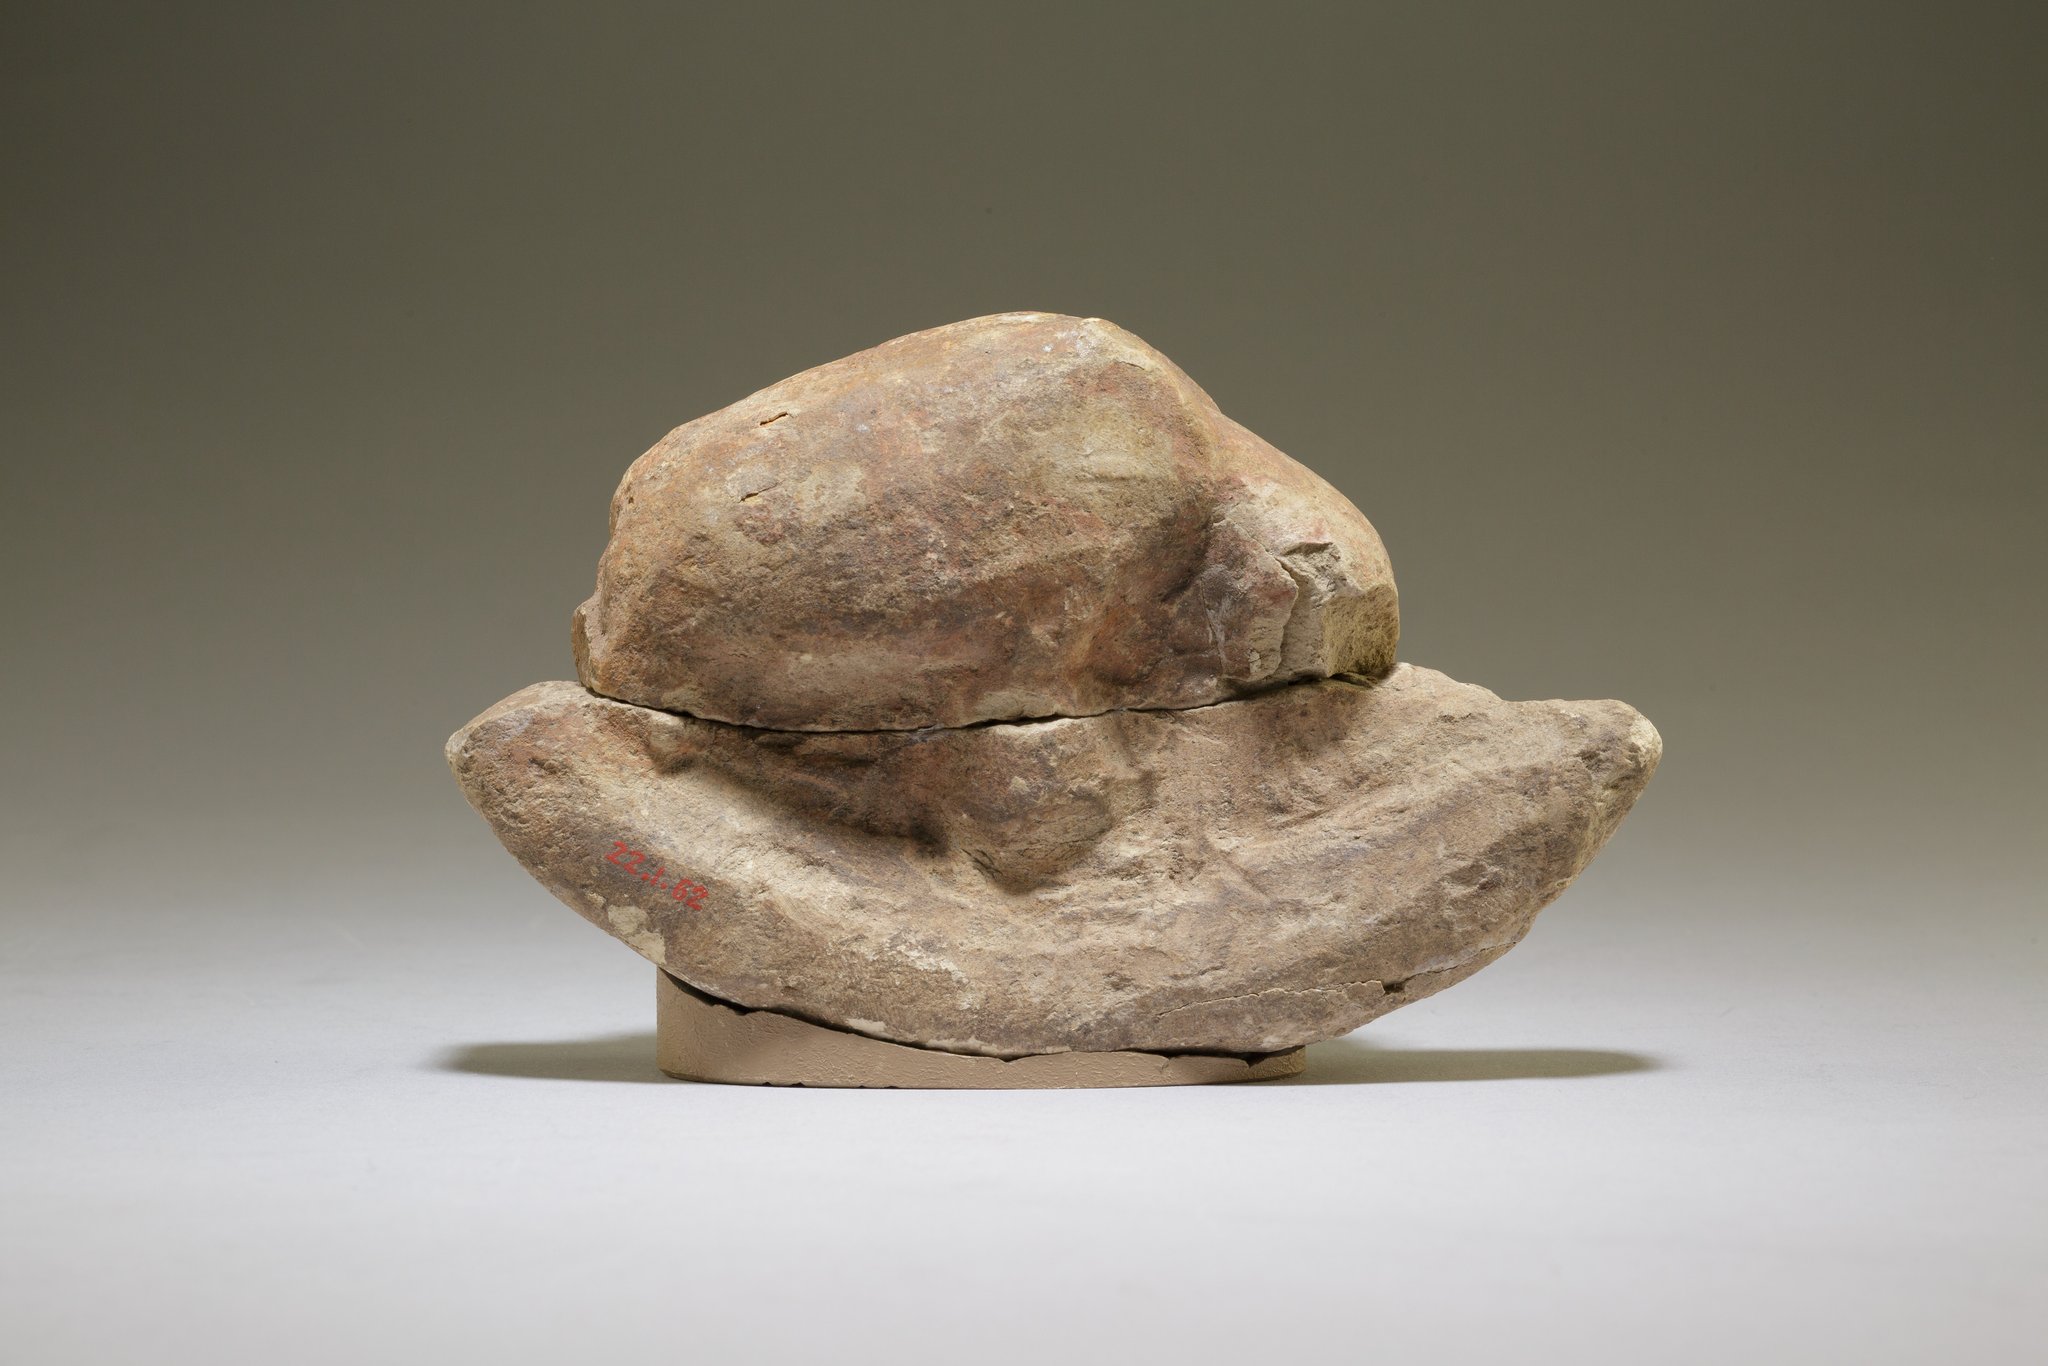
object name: model boat, hippopotamus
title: Model boat with hippopotamus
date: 1850-1750 BCE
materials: limestone, paint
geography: egypt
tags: hippos,boats